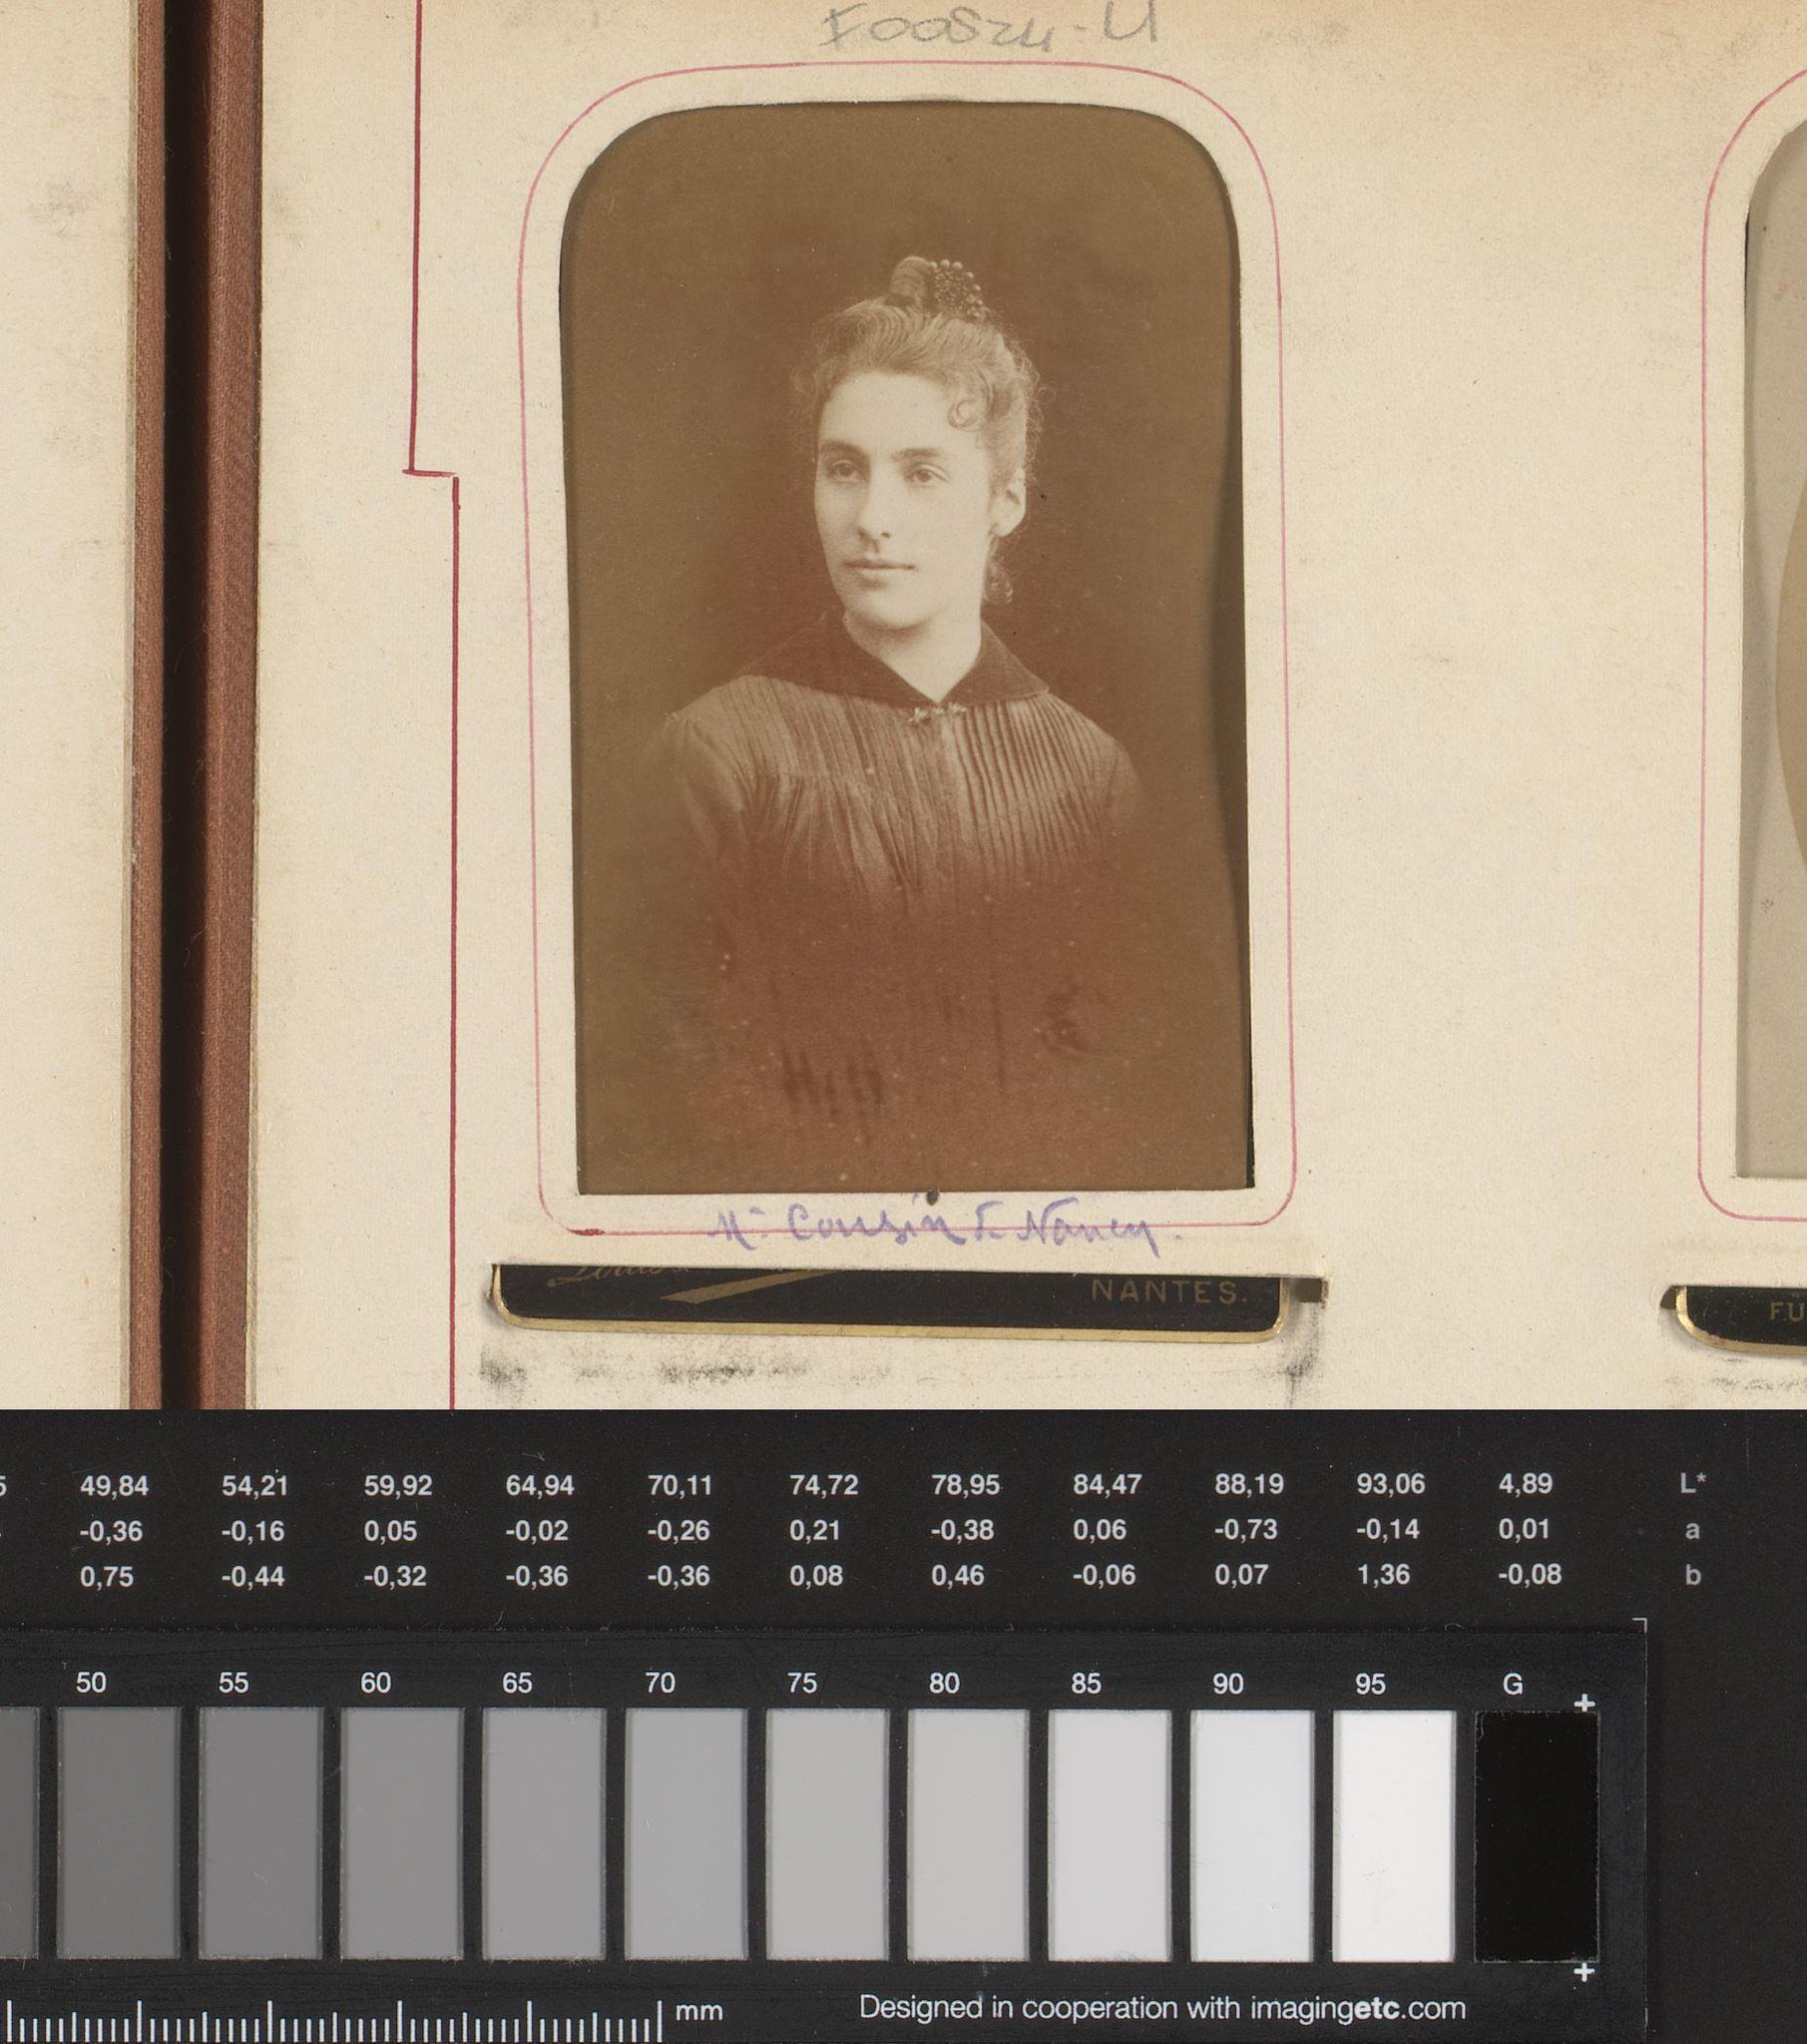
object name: carte de visite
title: Portret van een vrouw, aangeduid als Mme. Cousín de Nancy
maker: louis martin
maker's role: fotograaf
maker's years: -1925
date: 1886-1900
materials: cardboard, paper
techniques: albumen print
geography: nantes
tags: adult woman, anonymous historical person portrayed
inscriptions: inscription: ‘Premiers Prix/ Clichés conservés/ D.HUTINET-PARIS’, address: ‘10, rue du Calvaire/ NANTES’